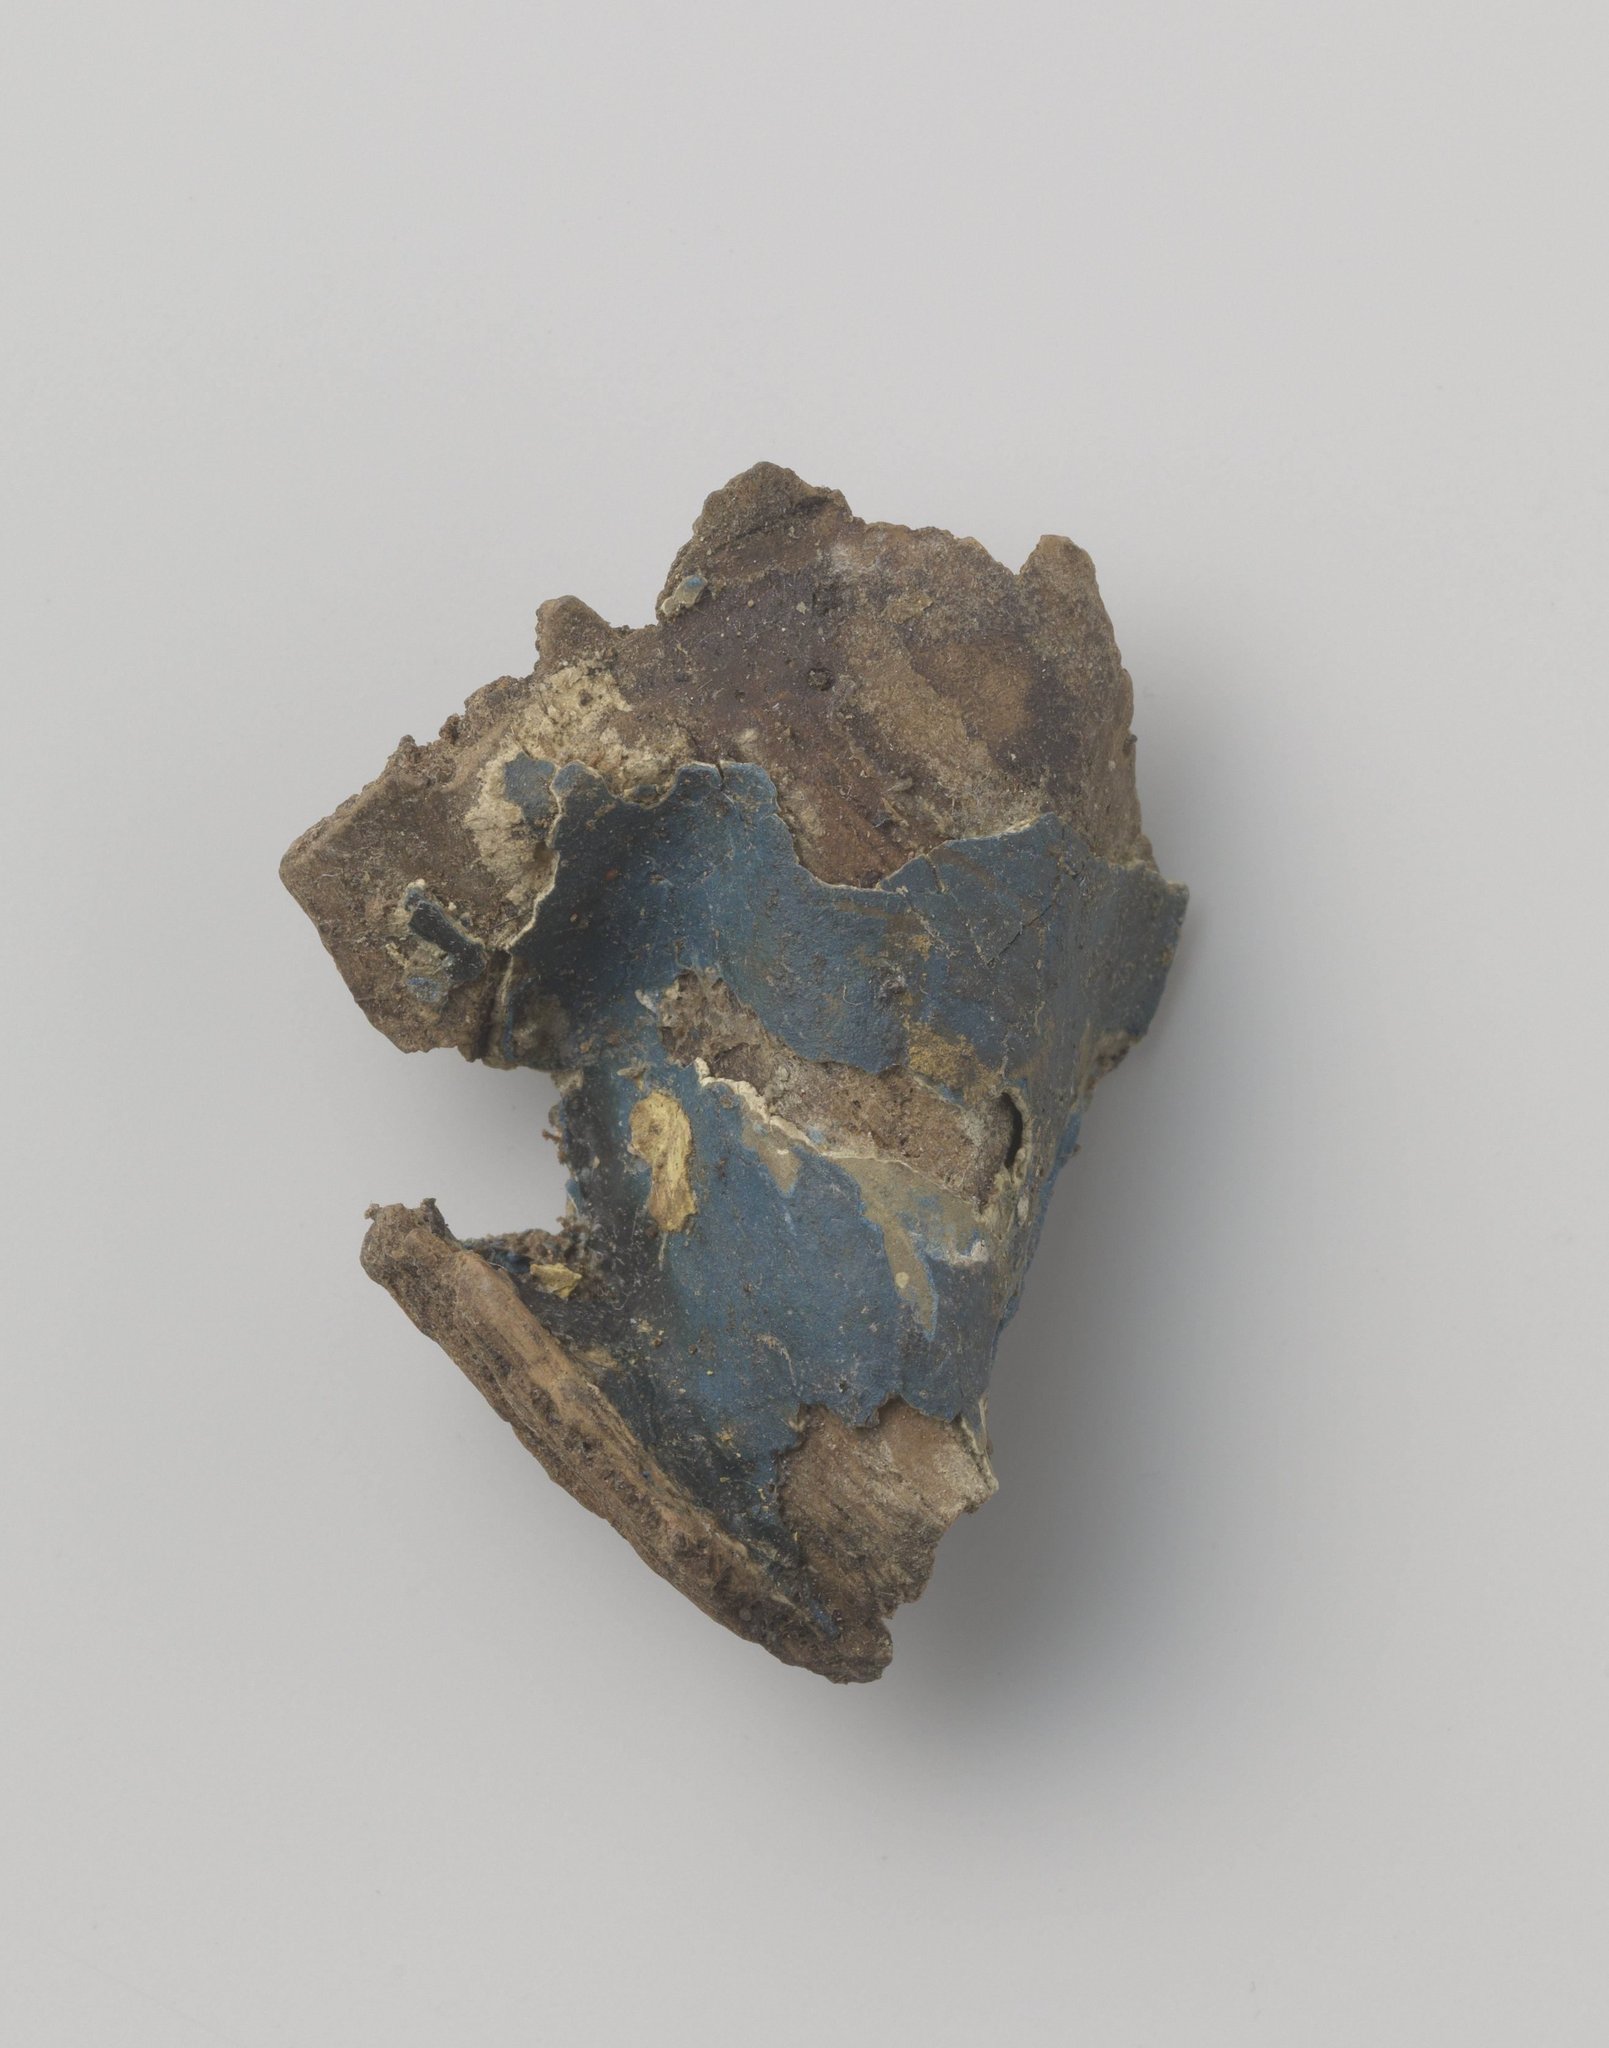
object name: fragment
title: Fragment; (mogelijk) behorend tot het retabel van Soest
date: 1475-1499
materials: wood